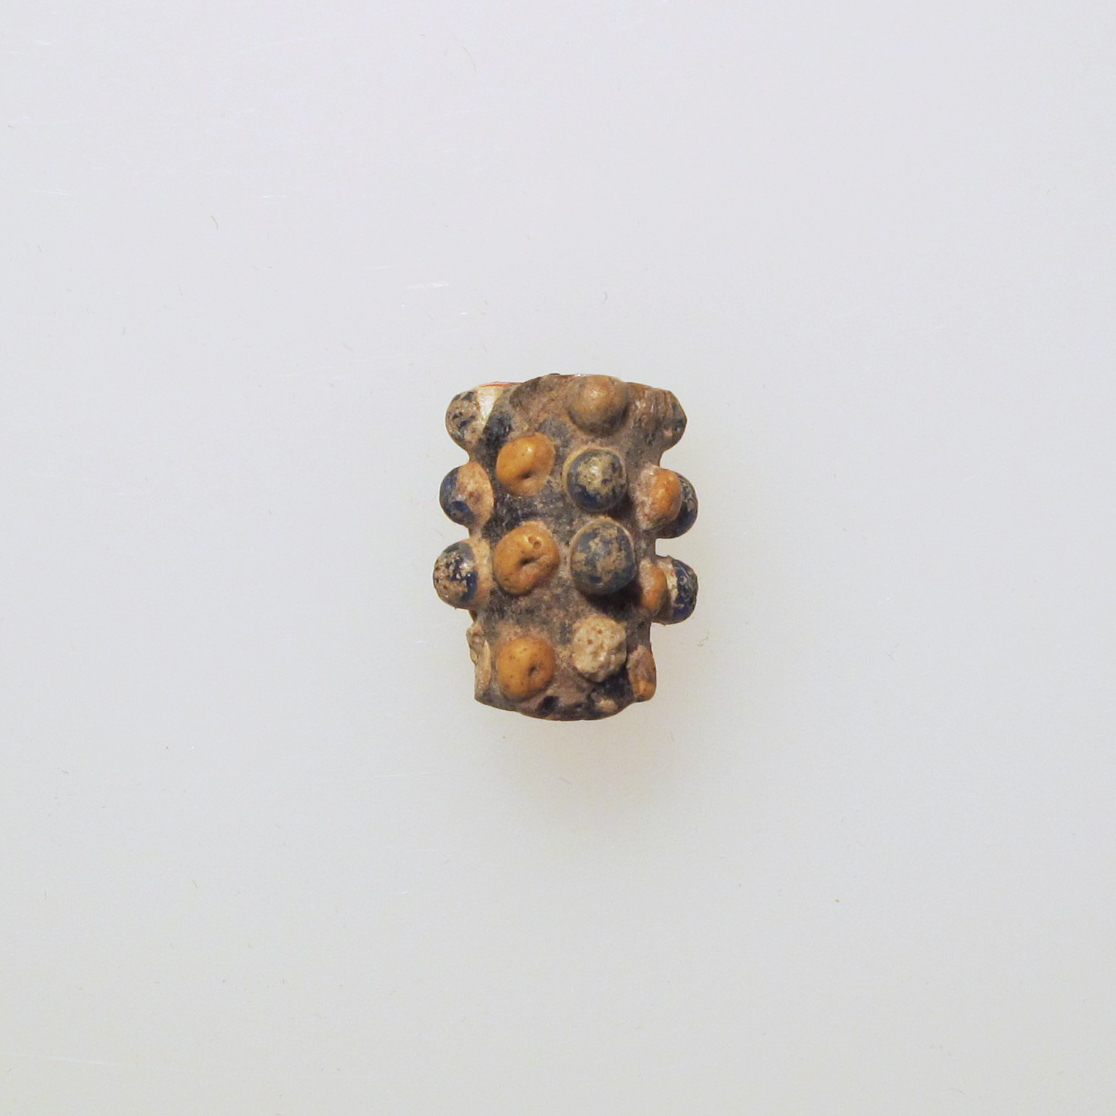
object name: bead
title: Glass bead with knobs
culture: carthaginian or phoenician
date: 500-201 BCE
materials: glass